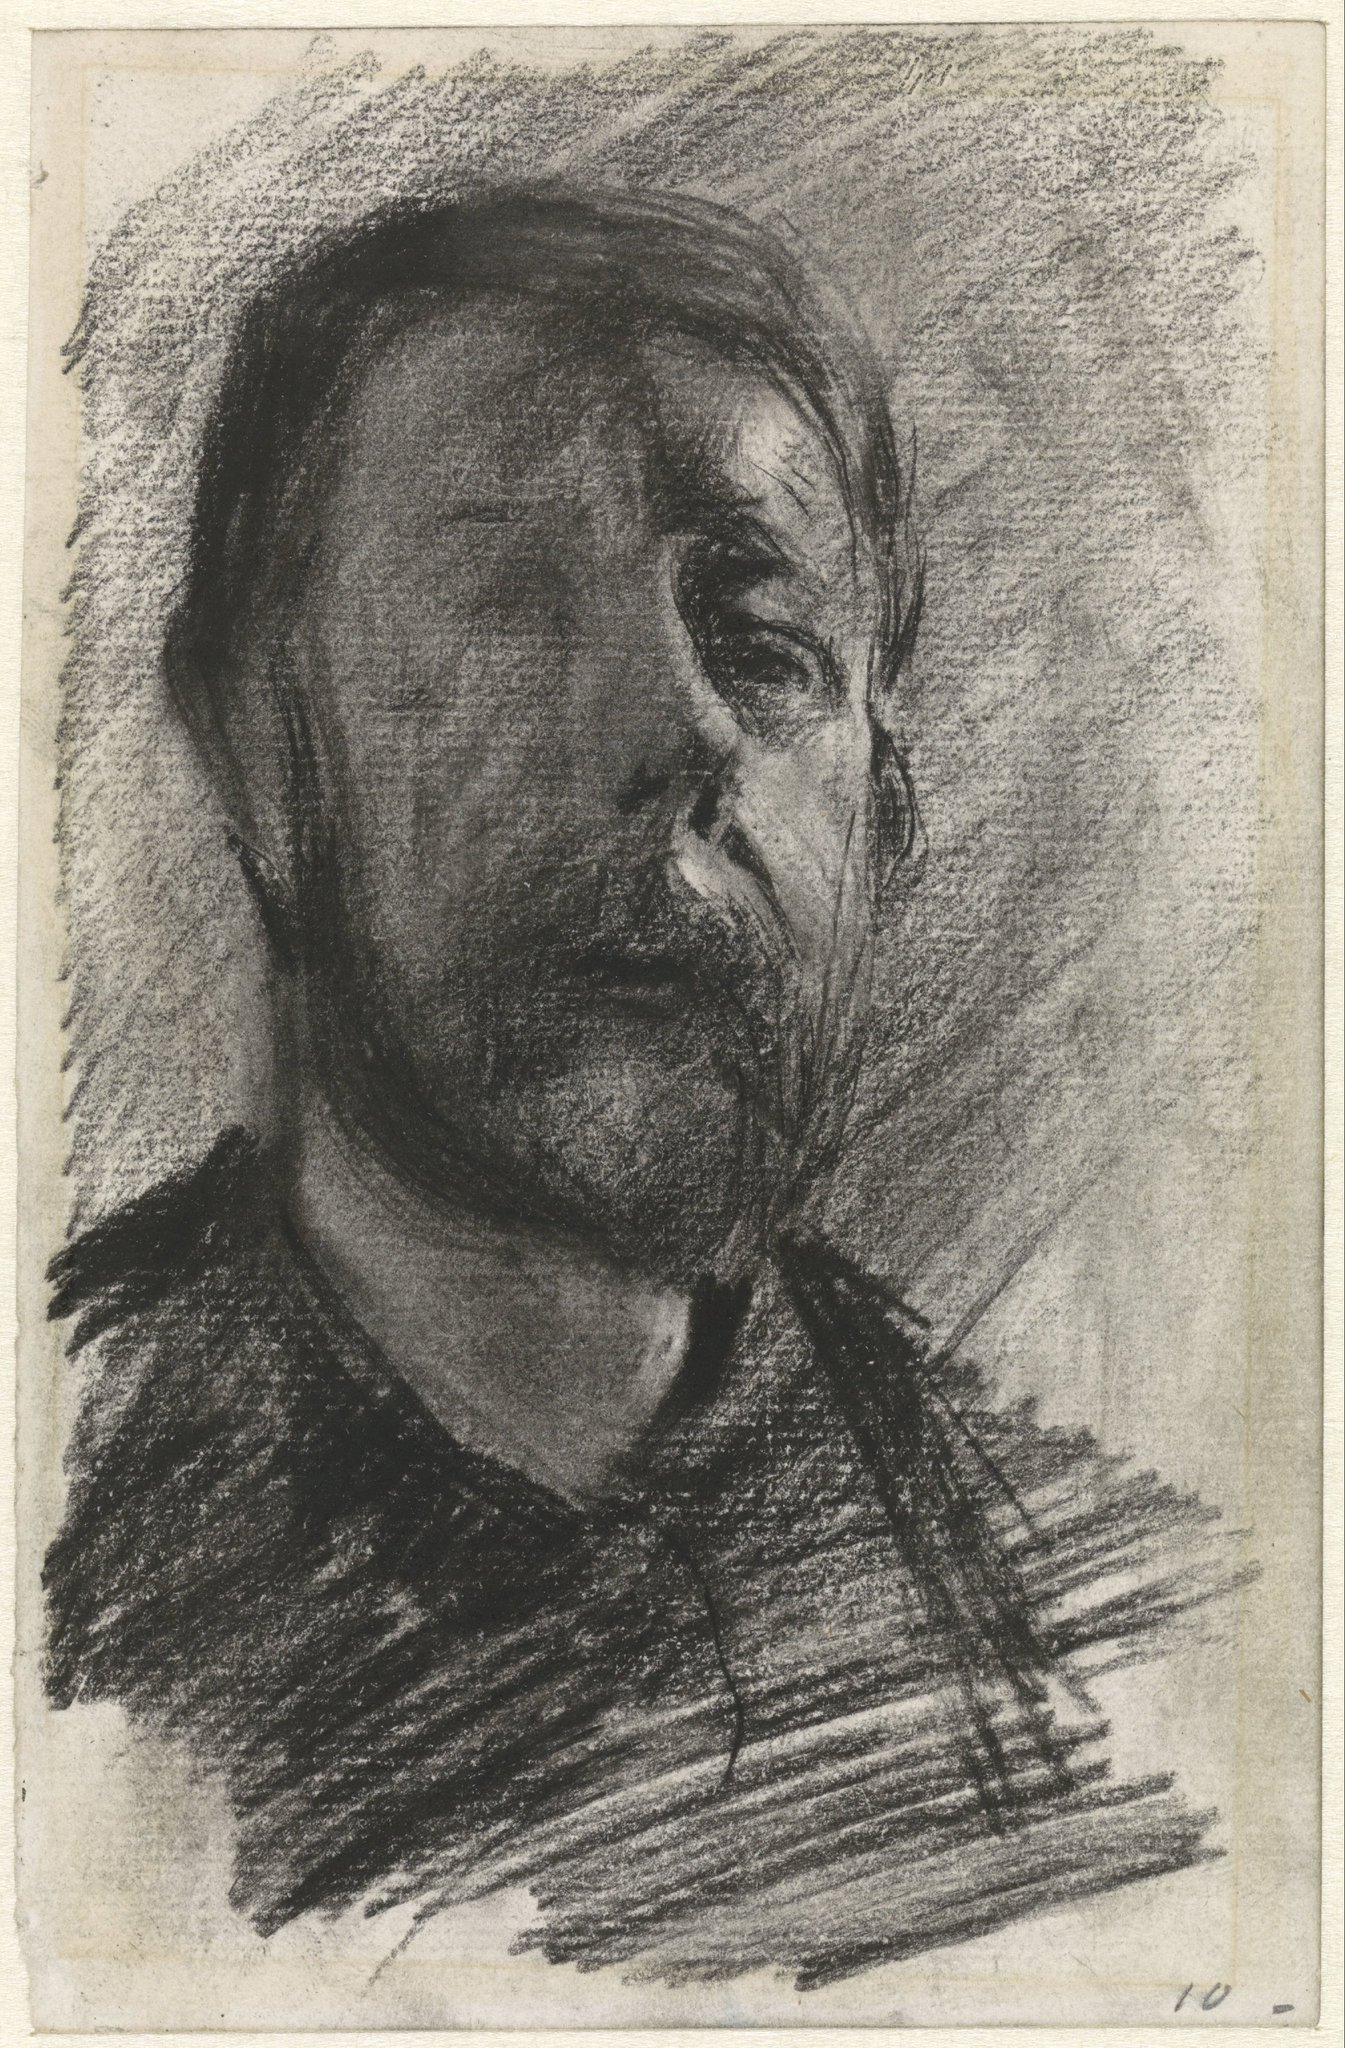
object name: drawing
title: Zelfportret van George Hendrik Breitner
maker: george hendrik breitner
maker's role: draughtsman, painter, print maker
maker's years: 1857-1923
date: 1880-1923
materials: chalk, paper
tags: amsterdam, painter, print maker, draughtsman, george hendrik breitner, historical persons, portrait, self-portrait of painter, portrait, self-portrait of artist, portrait, self-portrait of draughtsman